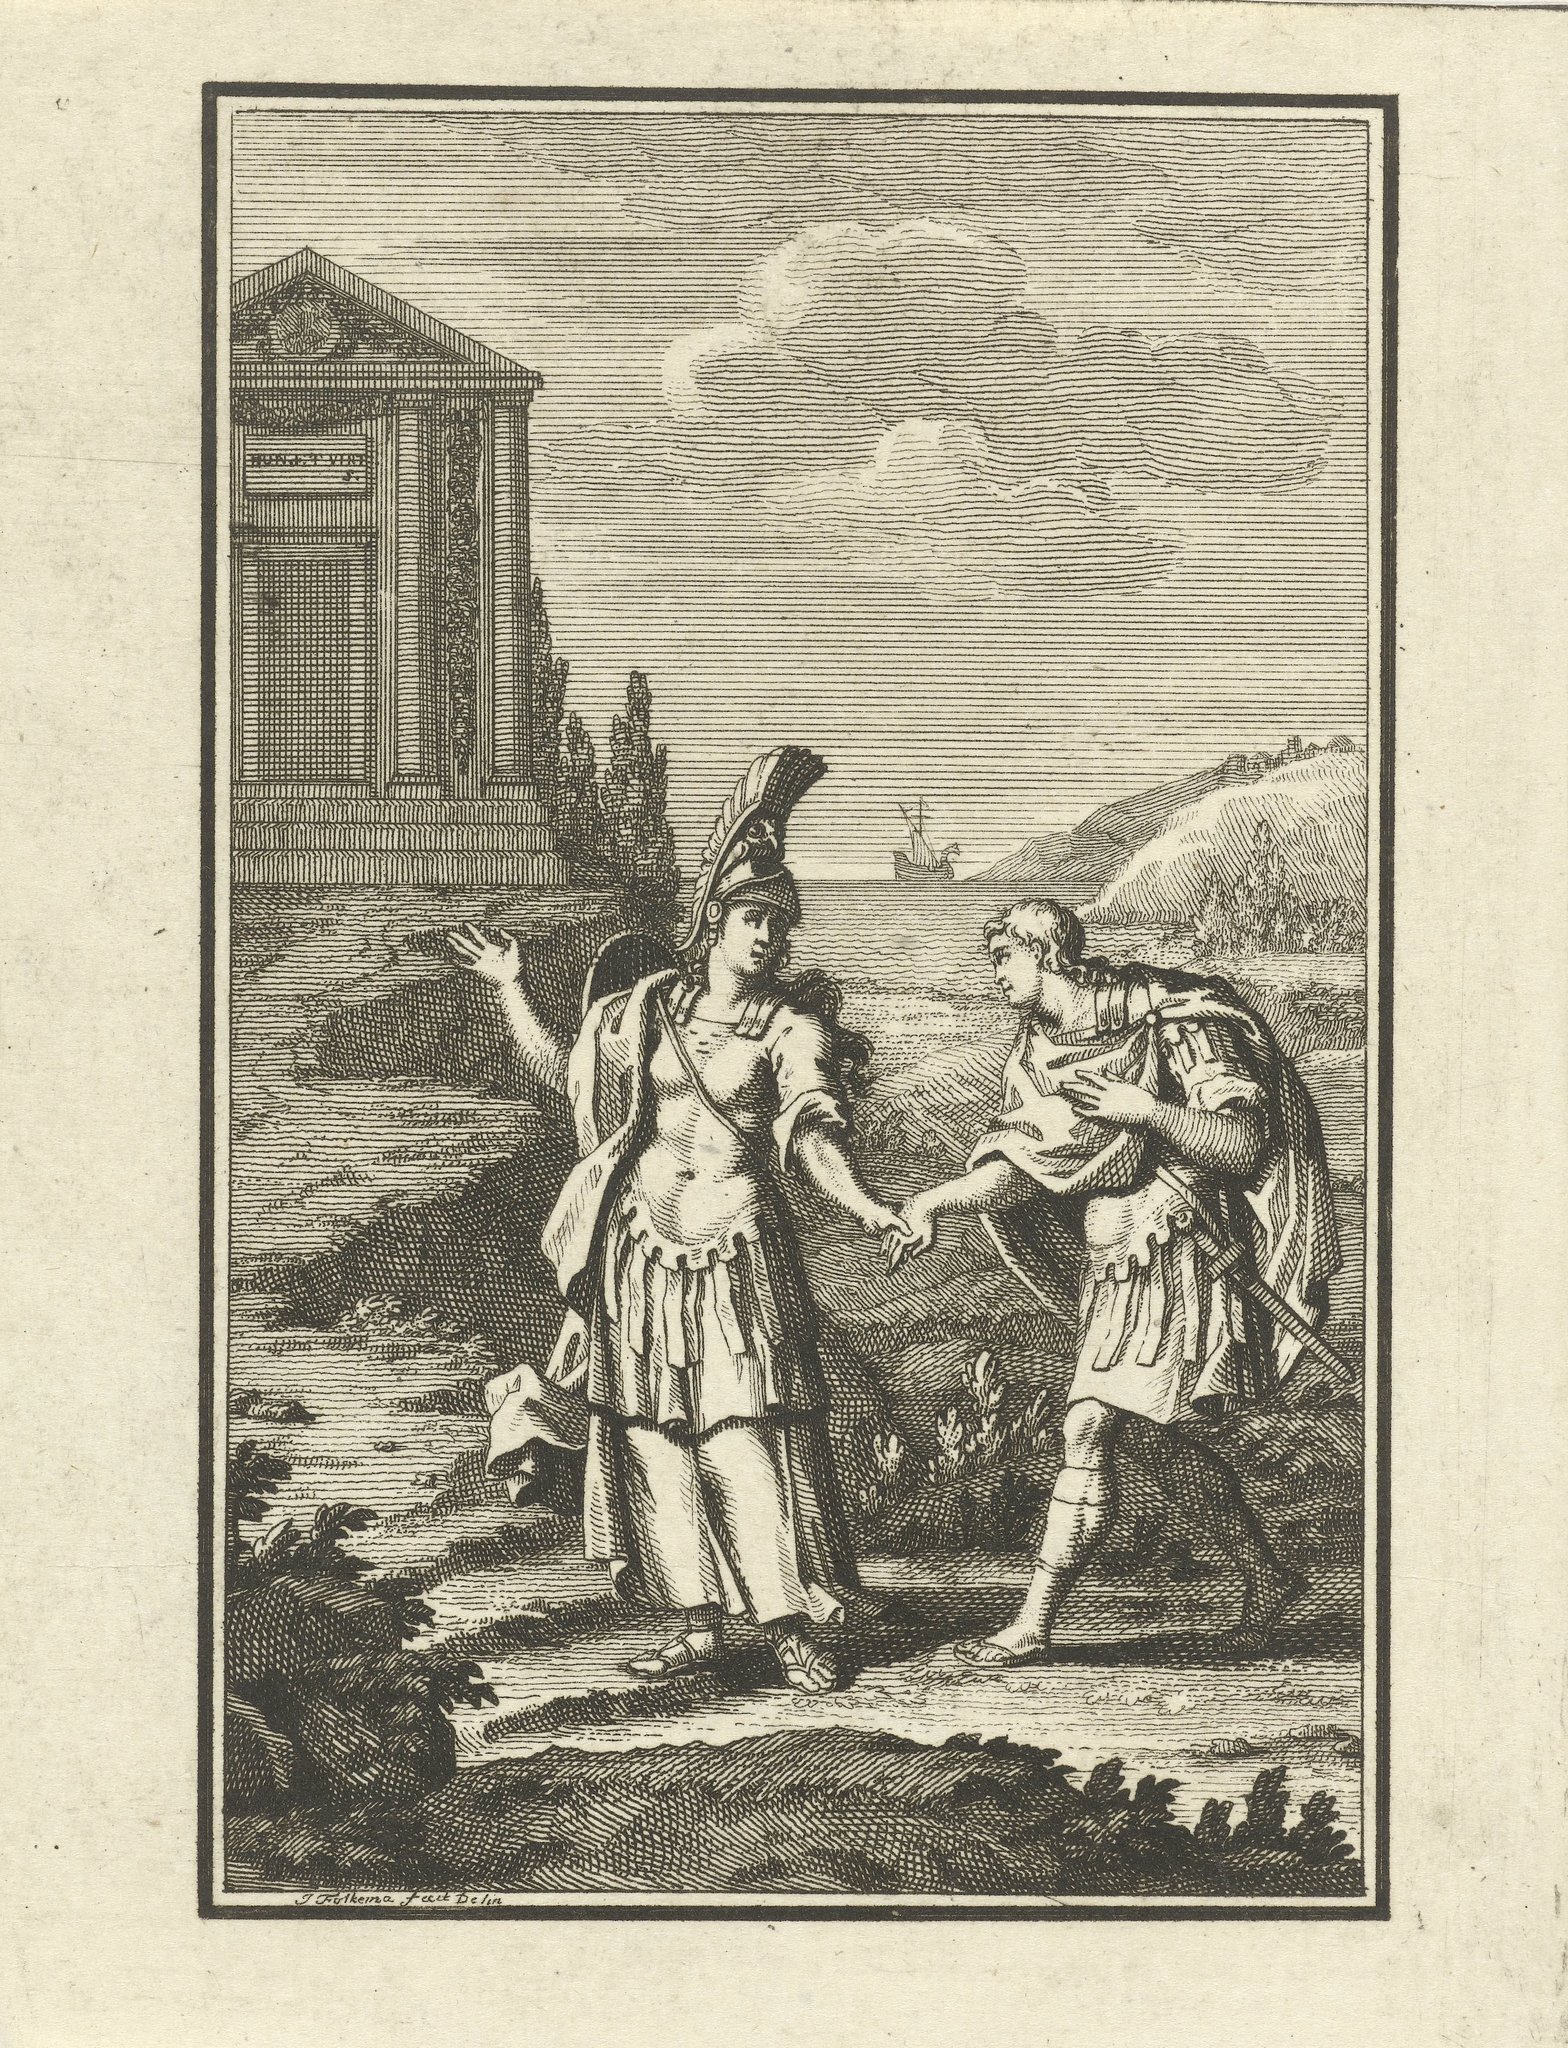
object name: print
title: Avonturen van Telemachus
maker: jacob folkema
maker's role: draughtsman, print maker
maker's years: 1692-1767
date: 1715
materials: paper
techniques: etching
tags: (story of) minerva (pallas, athena), (story of) telemachus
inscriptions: collector's mark: Lugt 2228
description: Minerva heeft Telemachus bij de hand genomen en wijst hem op een tempel. Illustratie vervaardigd bij een verhaal uit "Avonturen van Telemachus", geschreven door François de Fénélon.